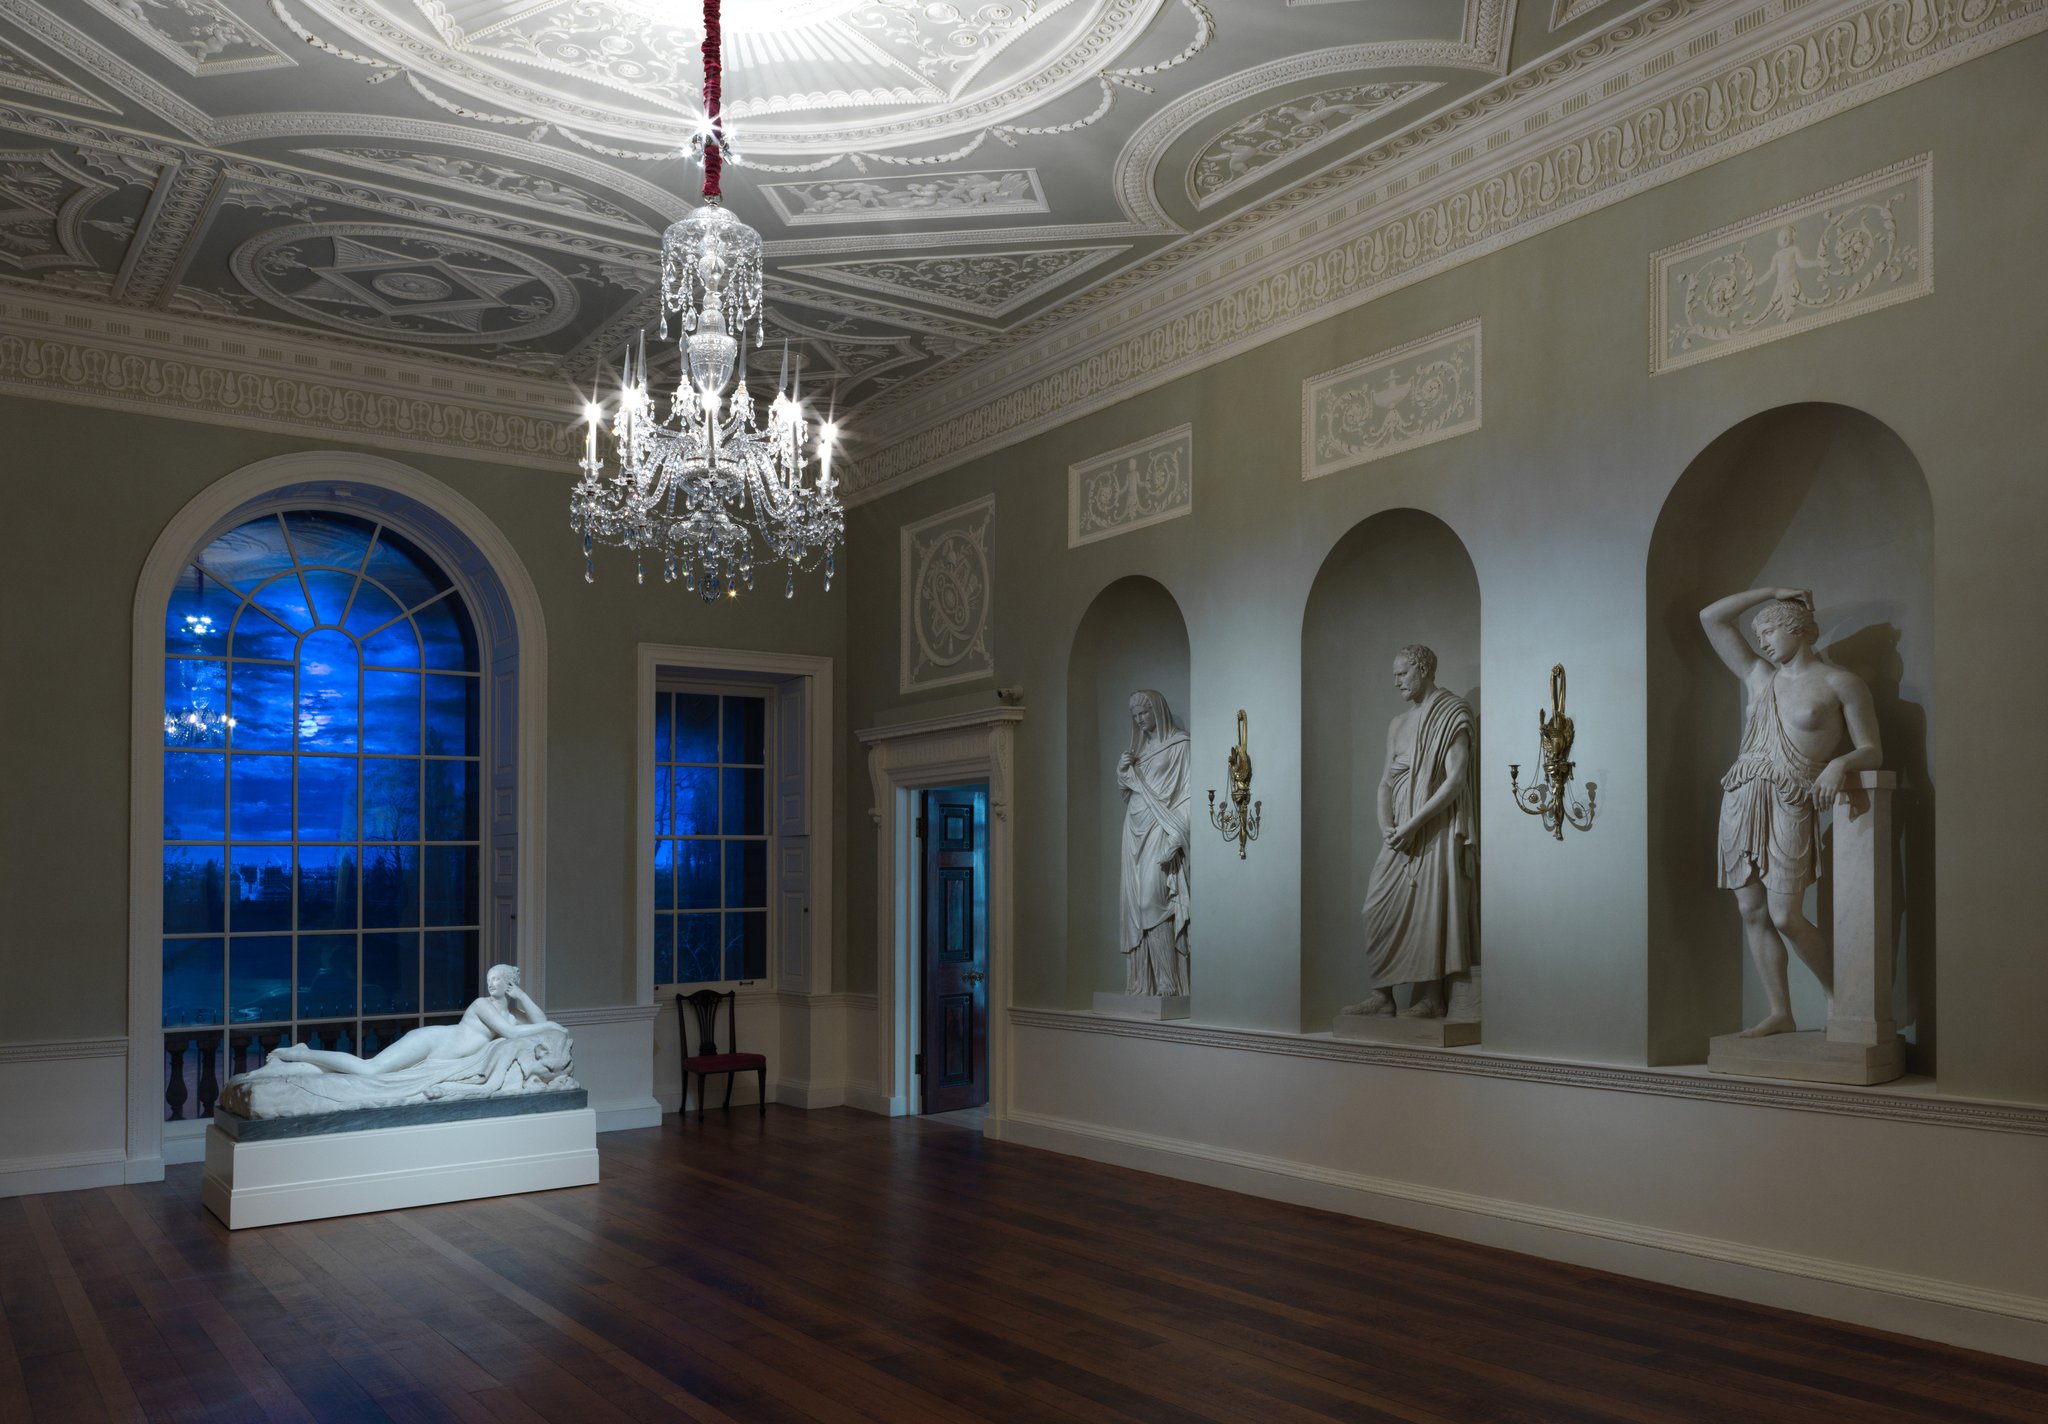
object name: period room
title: Dining room from Lansdowne House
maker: robert adam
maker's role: designer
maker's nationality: british, scottish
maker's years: 1728-1792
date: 1766-1769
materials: plaster, stone, wood